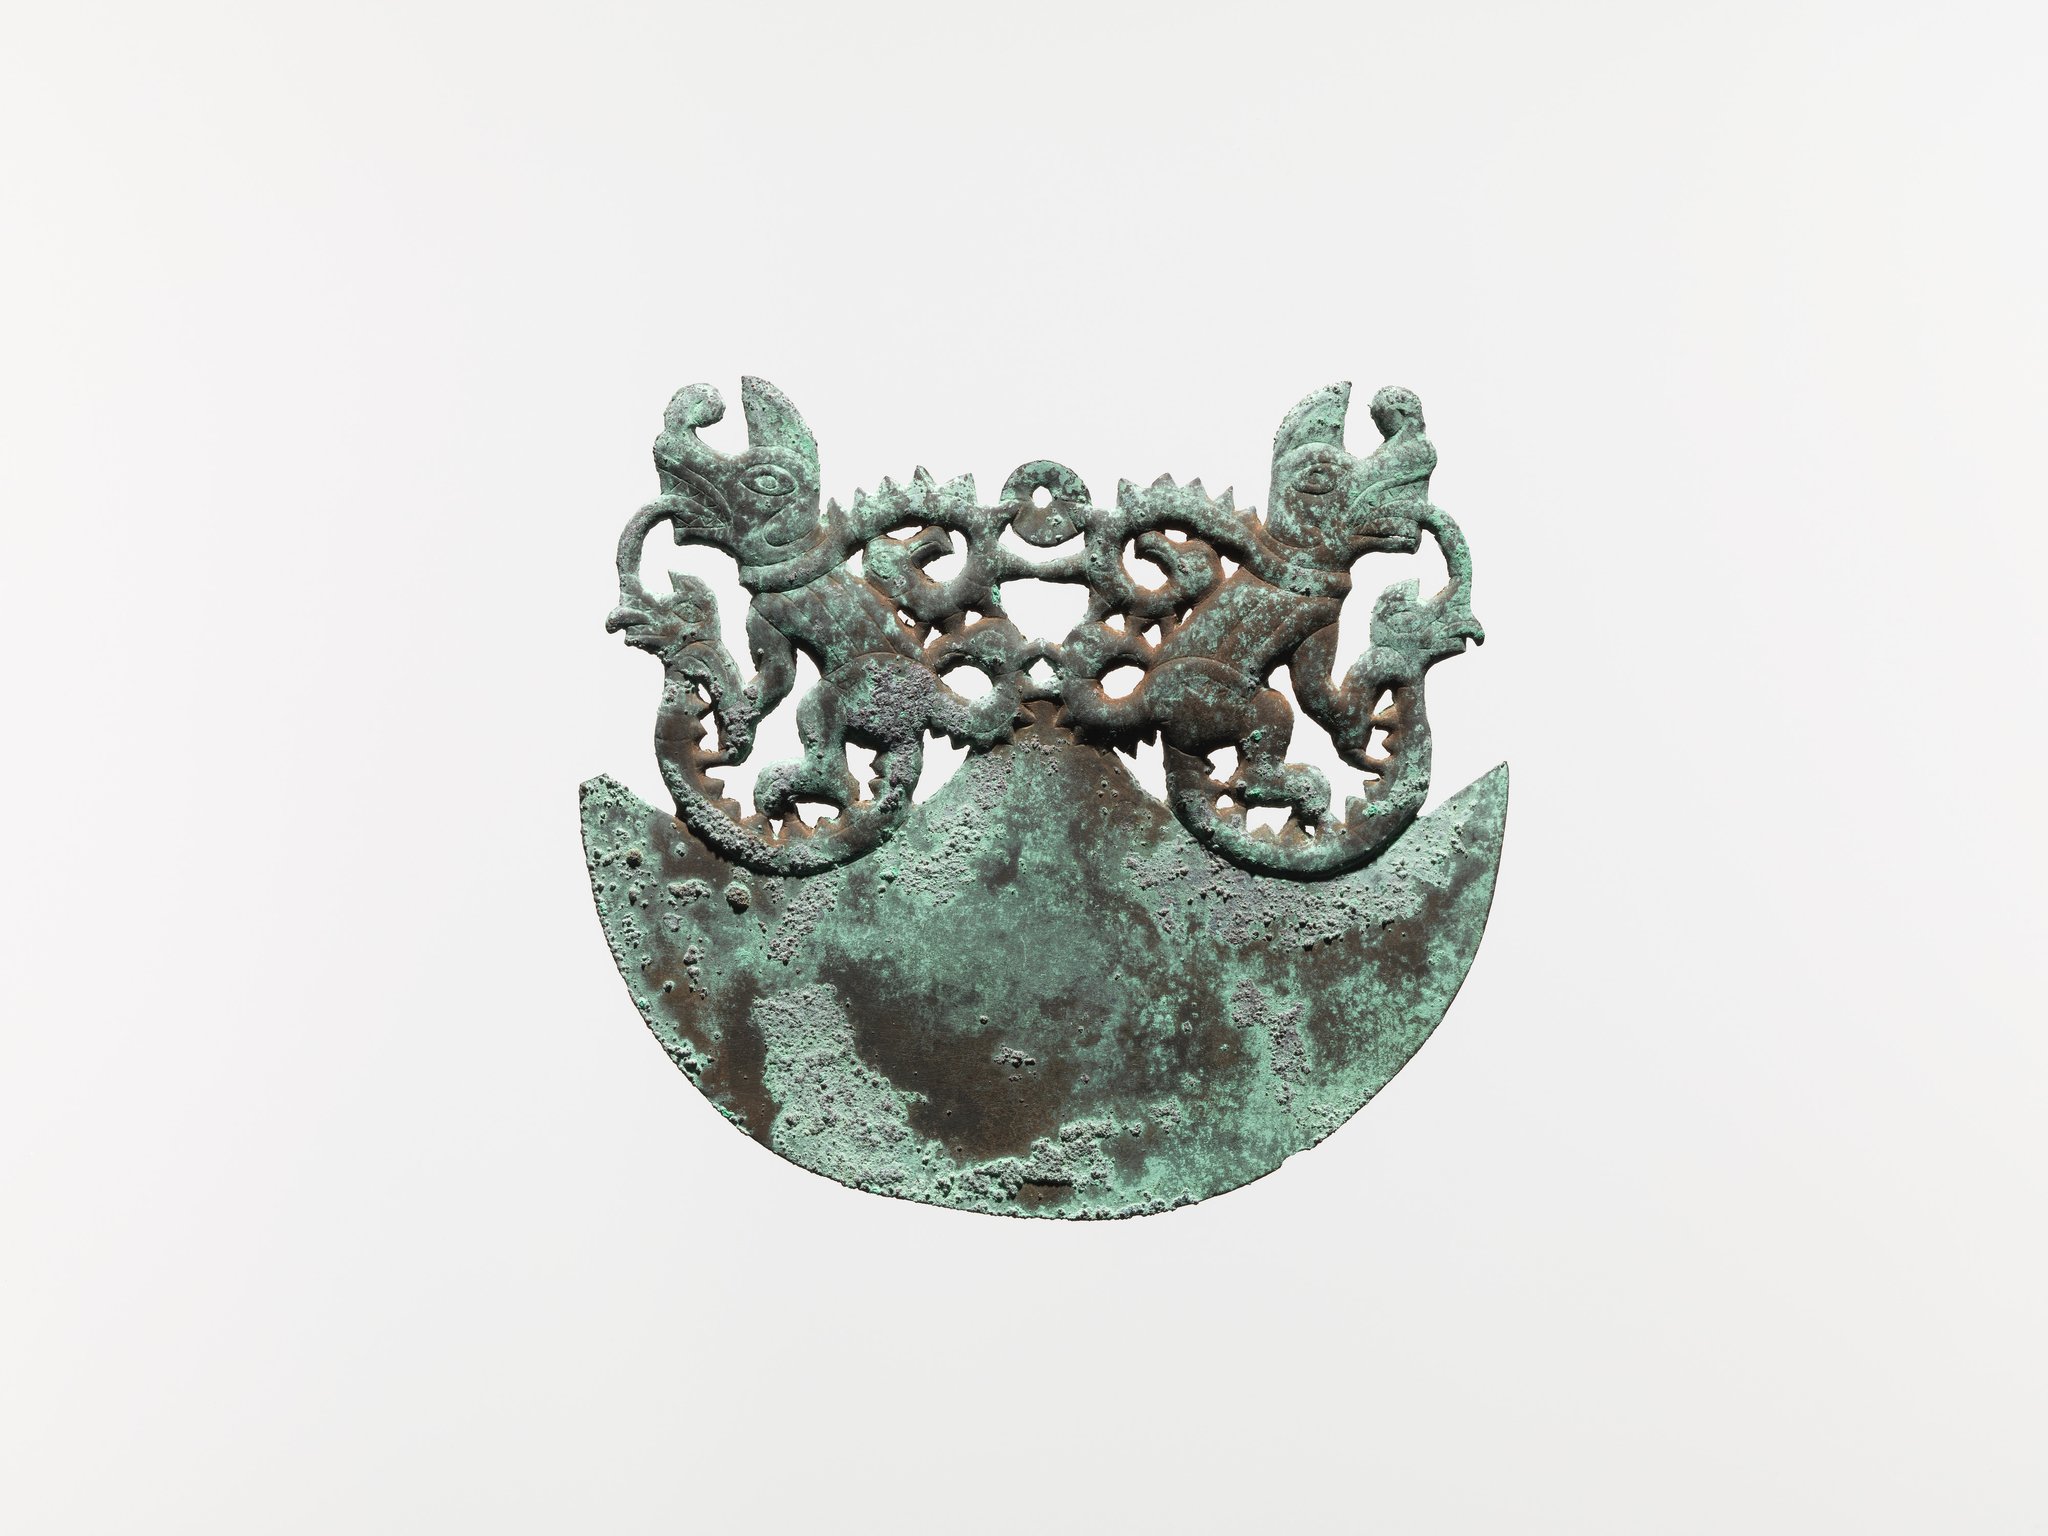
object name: ornament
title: Crescent Ornament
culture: moche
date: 501-700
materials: copper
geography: peru